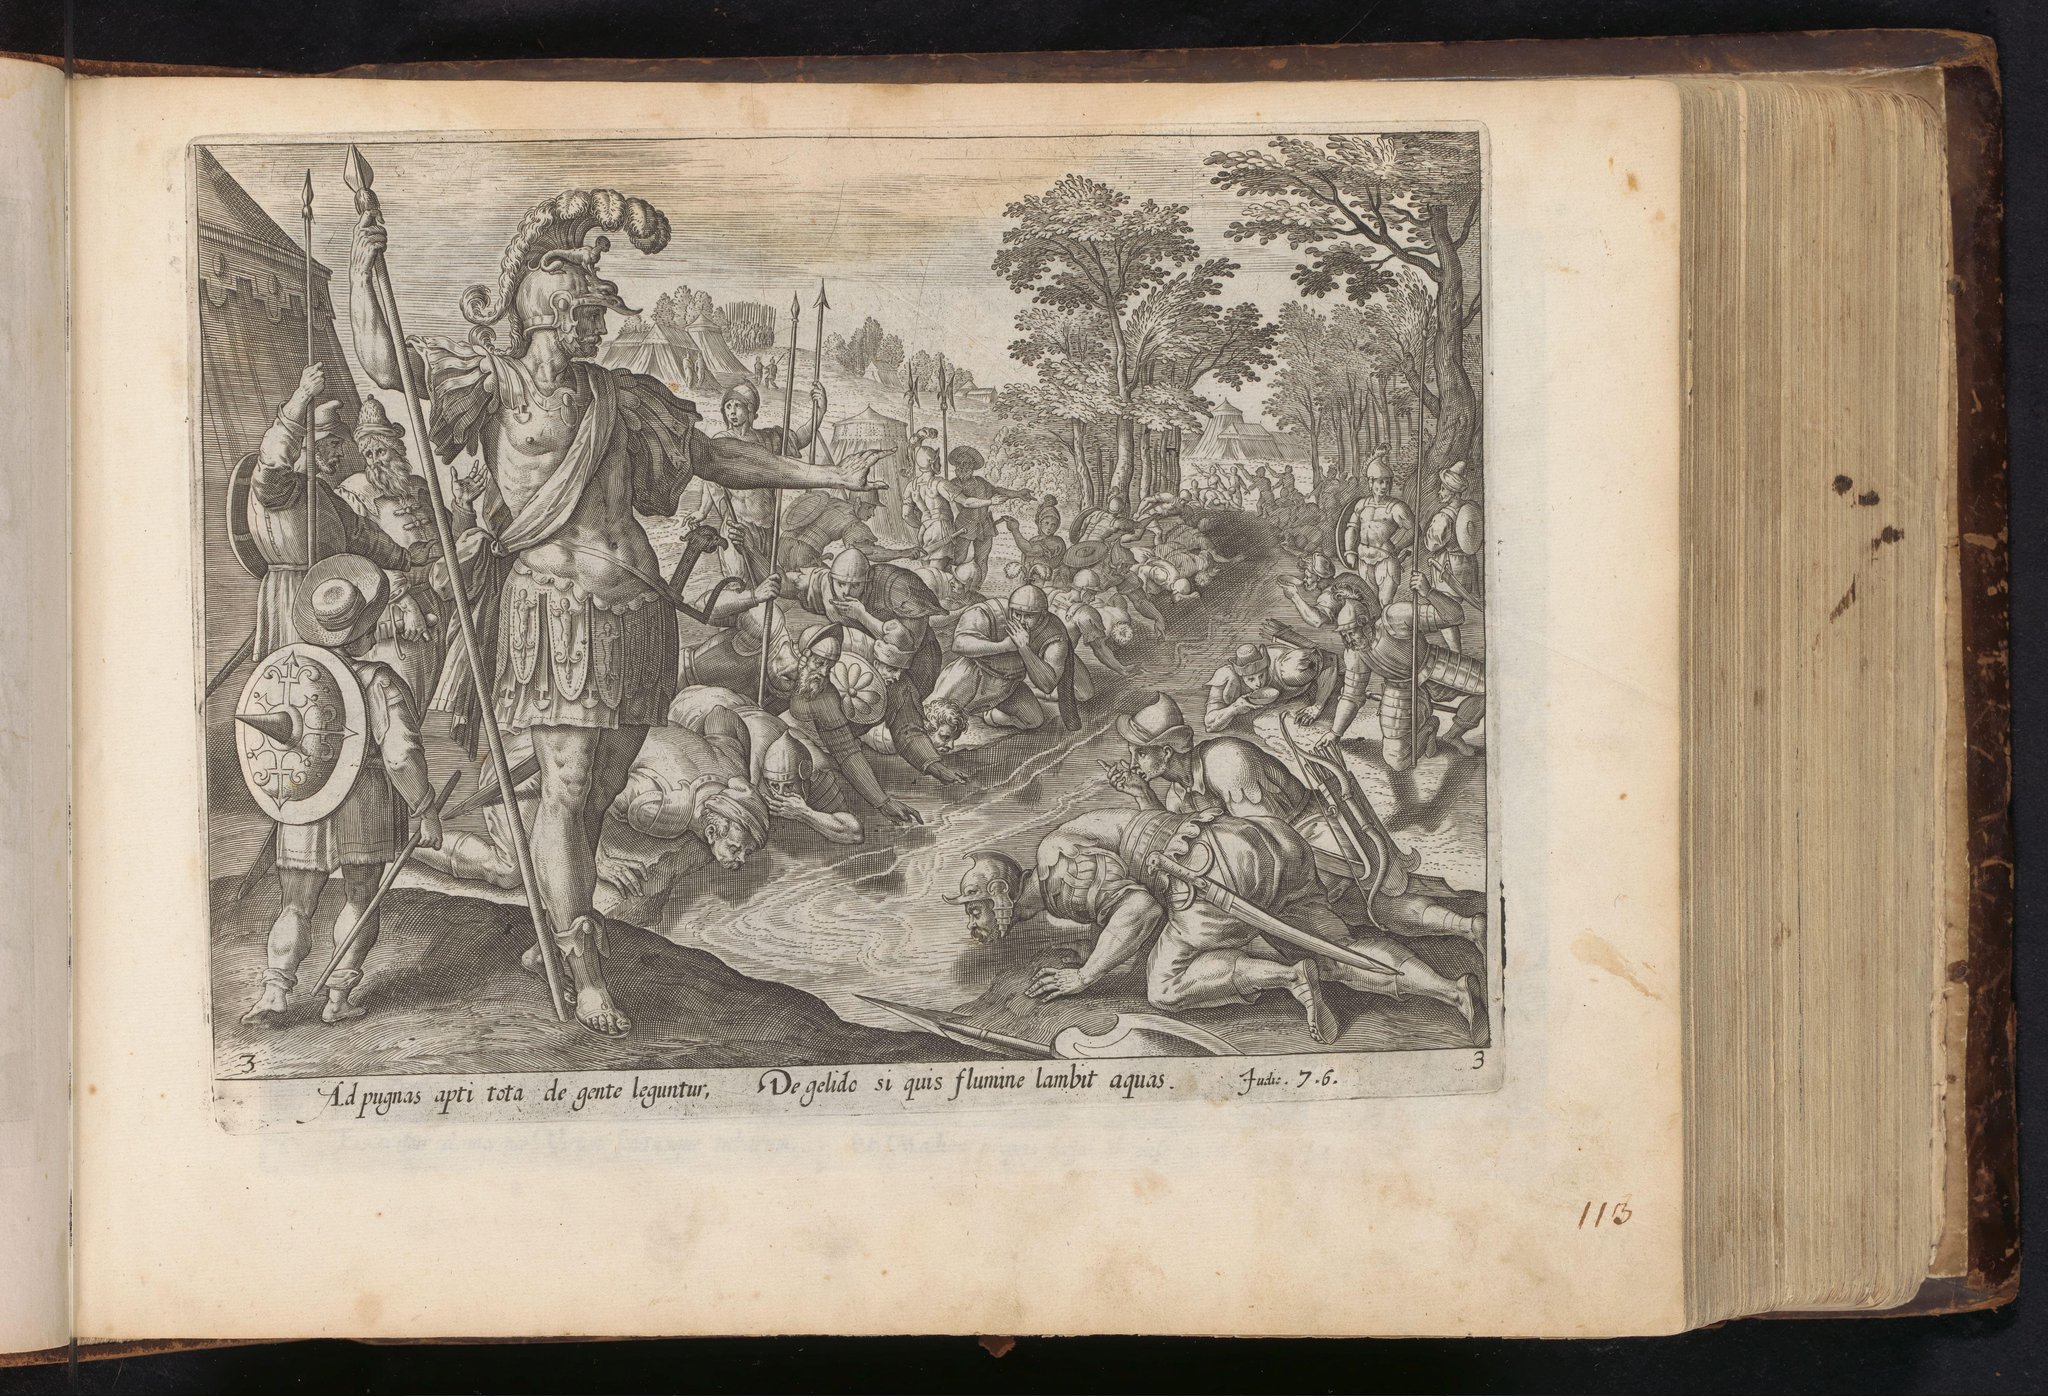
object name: album leaf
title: Selectie van Gideons manschappen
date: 1585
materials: paper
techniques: engraving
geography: amsterdam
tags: those who lap water by putting their hand to their mouth are separated from those who kneel down to drink the water ~ selection of gideon's men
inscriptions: number: ‘113’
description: Gideon heeft zijn mannen naar het water gebracht en laat hen drinken. Degenen die het water met hun tong oplikken neemt hij mee in de strijd. De mannen die knielen om het water te drinken worden naar huis gestuurd. Onder de voorstelling een verwijzing in het Latijn naar de Bijbeltekst in Ri. 7:6. Deze prent maakt deel uit van een album.